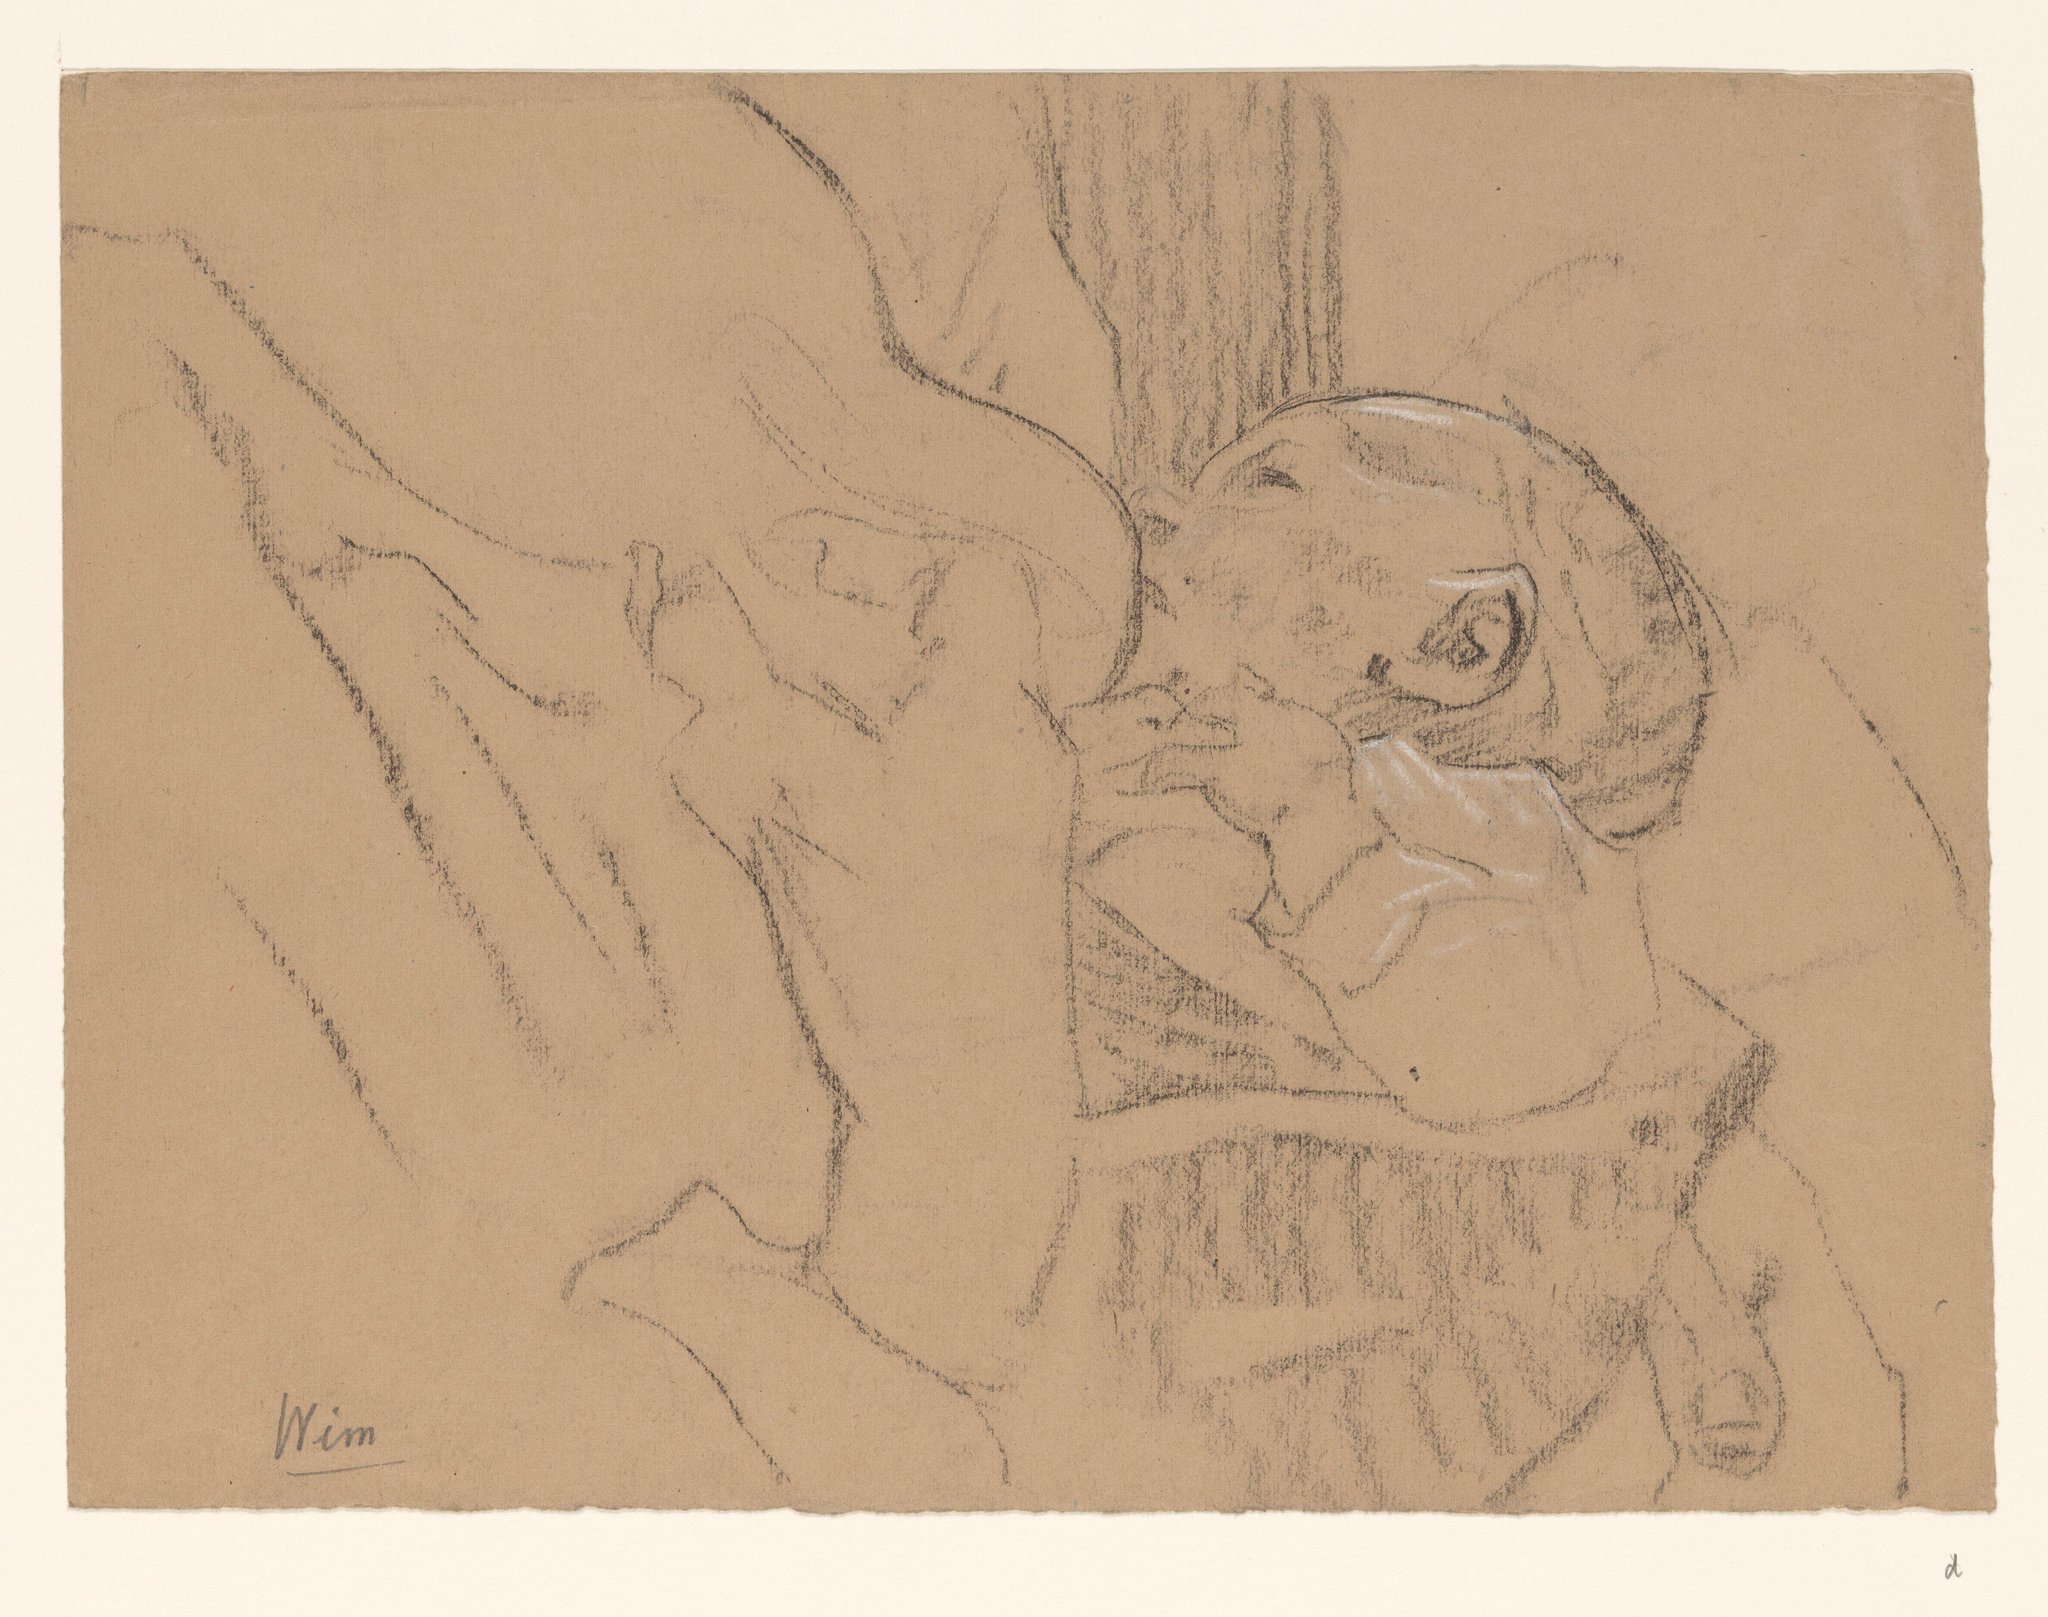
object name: drawing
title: Kind van Wilhelmus Johannes Steenhoff aan de borst van zijn moeder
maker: wilhelmus johannes steenhoff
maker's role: draughtsman, print maker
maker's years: 1863-1932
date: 1873-1932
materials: chalk, paper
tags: nursing, suckling